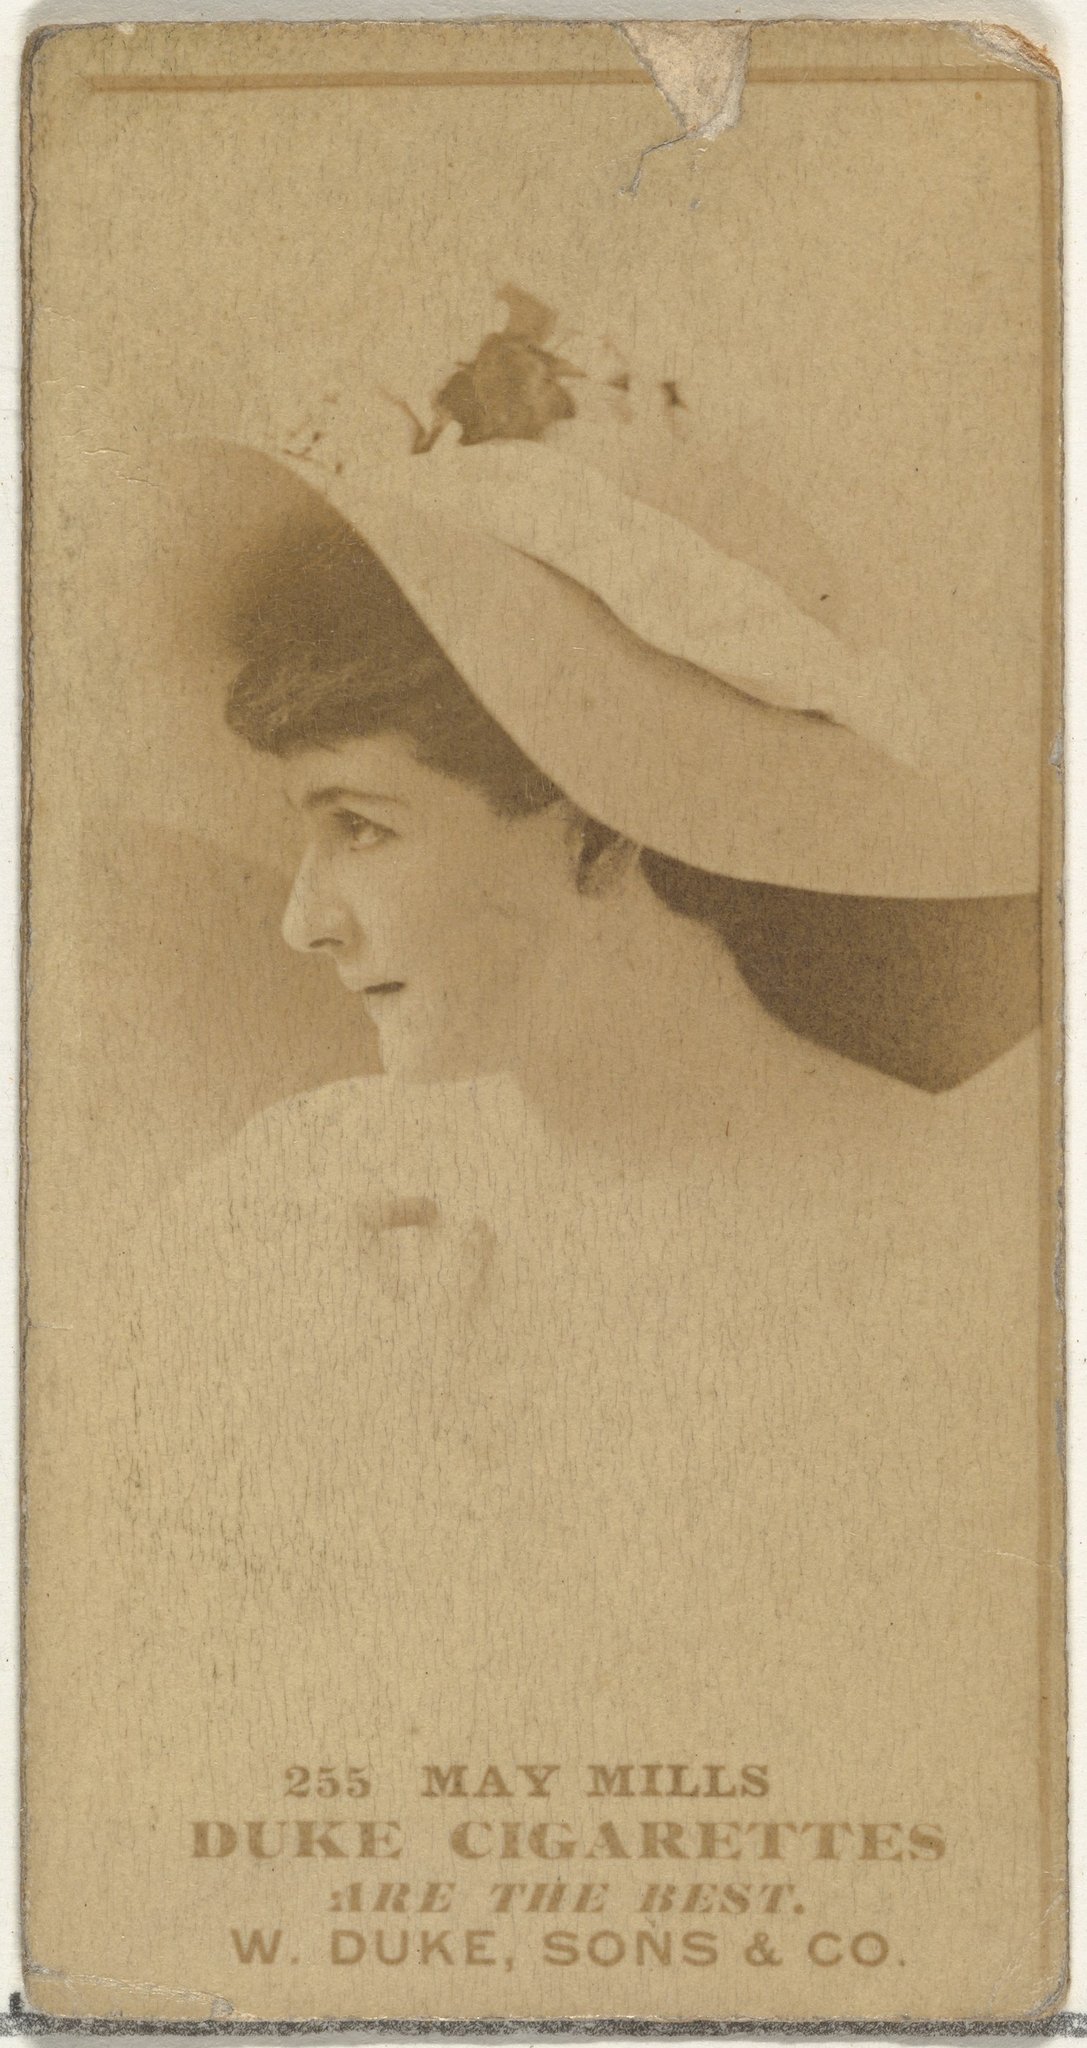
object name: photograph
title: Card Number 255, May Mills, from the Actors and Actresses series (N145-7) issued by Duke Sons & Co. to promote Duke Cigarettes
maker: w. duke, sons & co.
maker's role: publisher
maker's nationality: american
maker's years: 1870-1920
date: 1880-1889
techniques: albumen silver print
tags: women,actresses